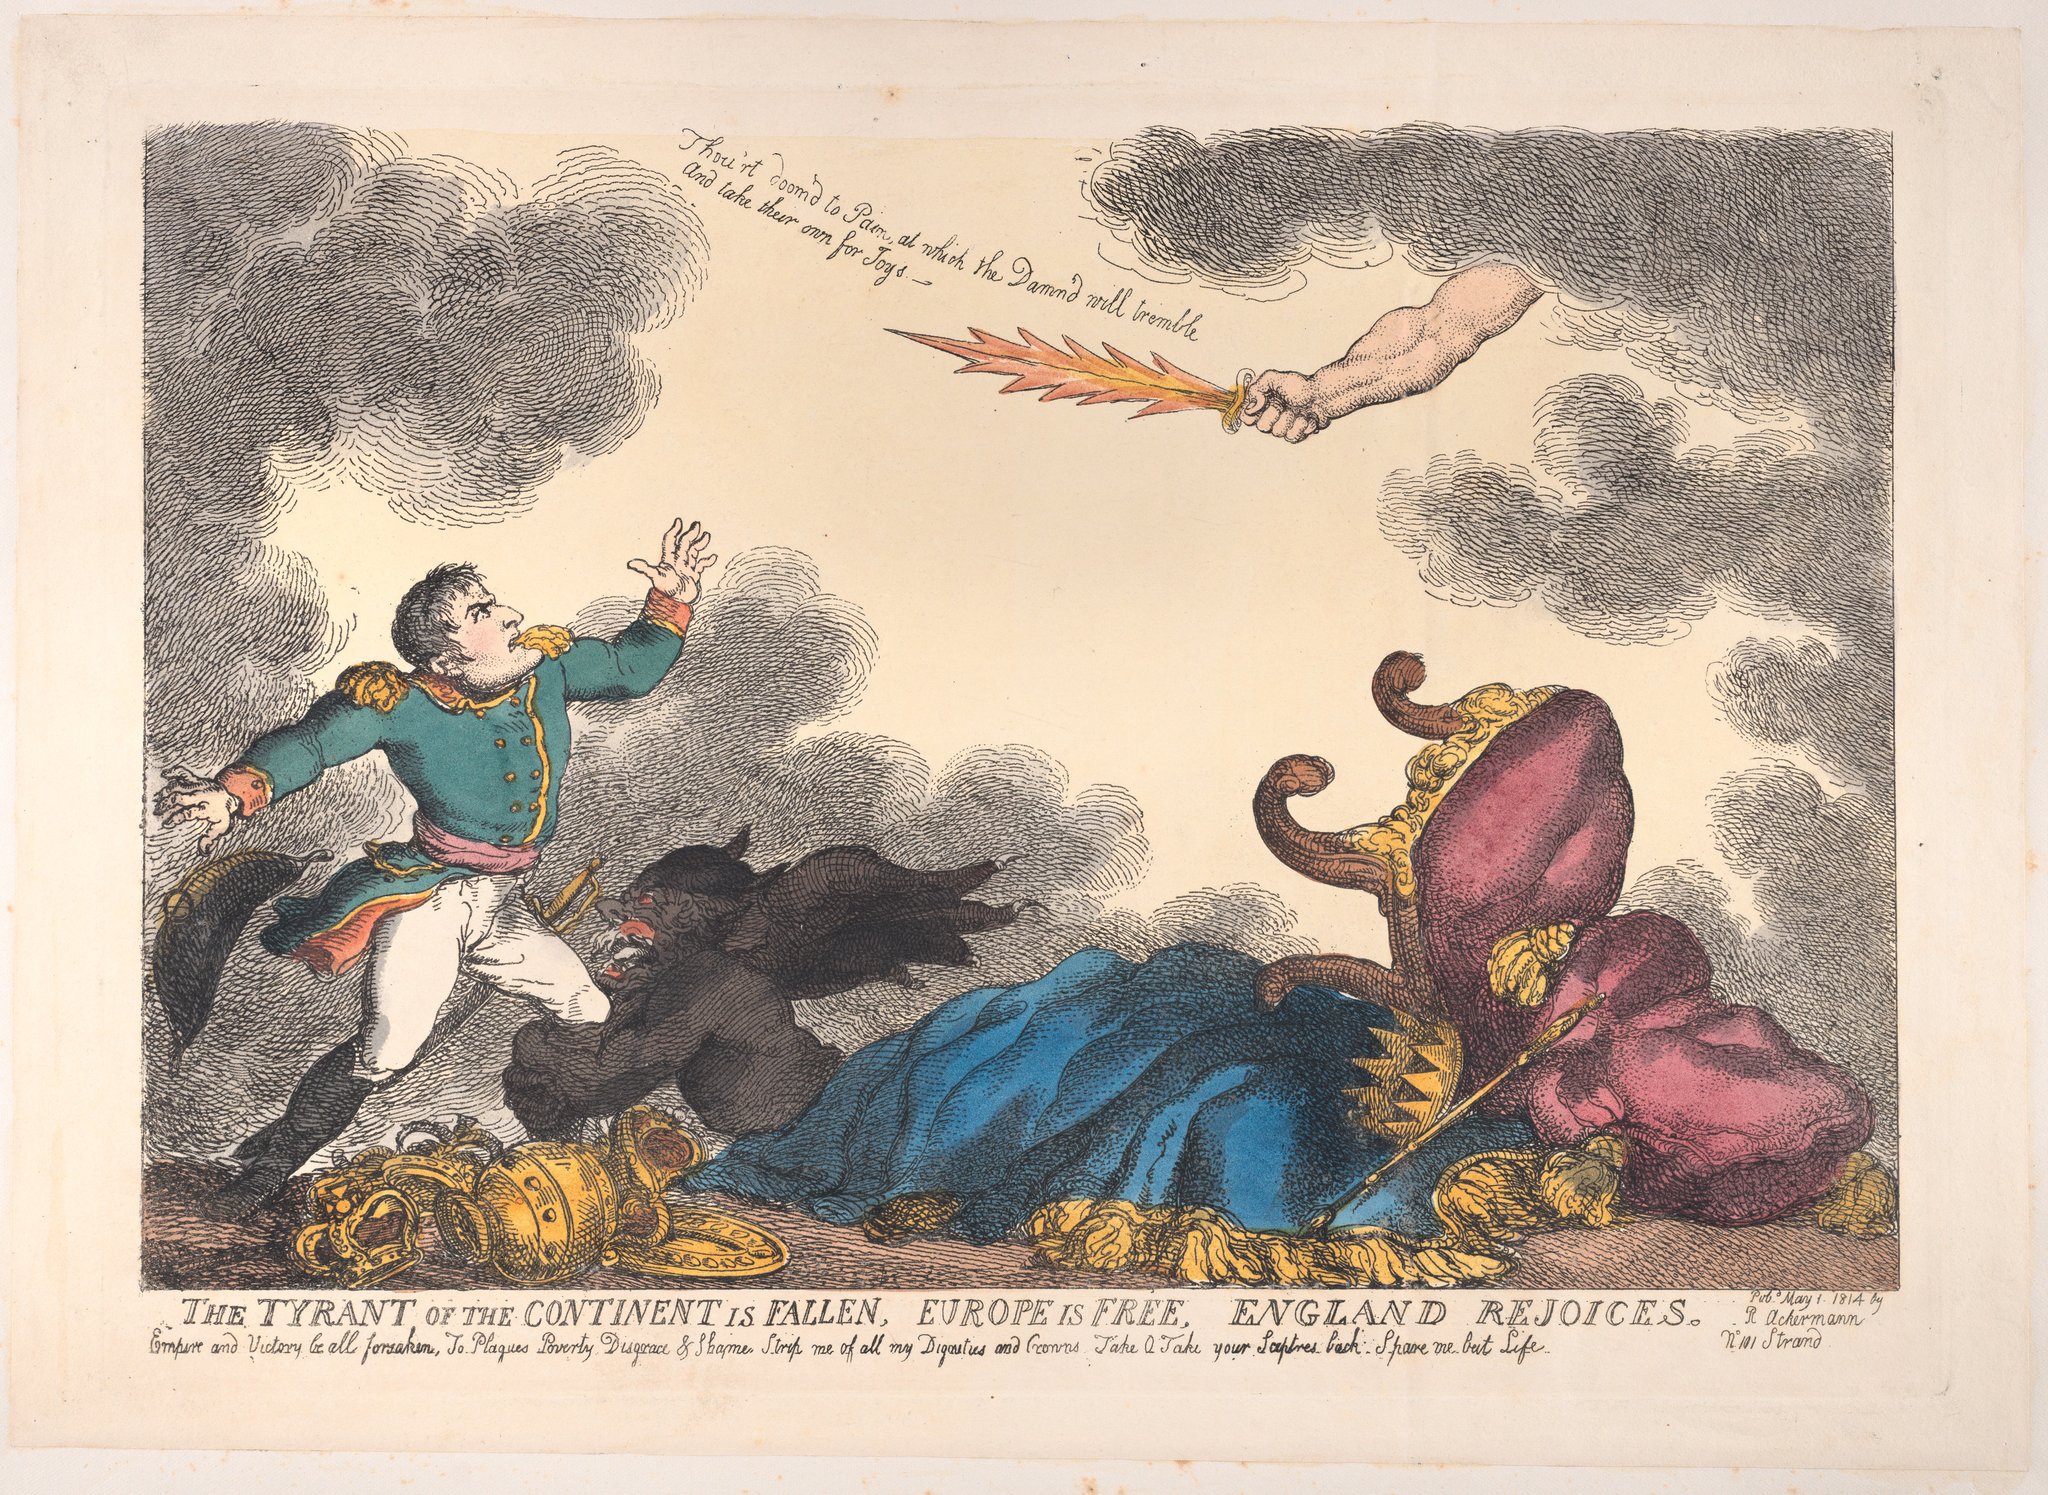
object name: print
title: The Tyrant of the Continent is Fallen, Europe is Free, England Rejoices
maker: thomas rowlandson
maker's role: artist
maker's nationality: british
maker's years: 1757-1827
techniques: etching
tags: satire,napoleon i,devil,politics